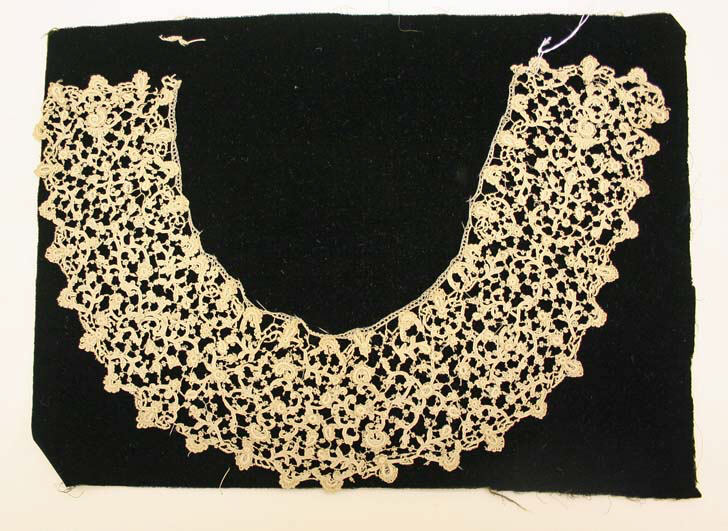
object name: collar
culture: italian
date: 1870-1889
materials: linen